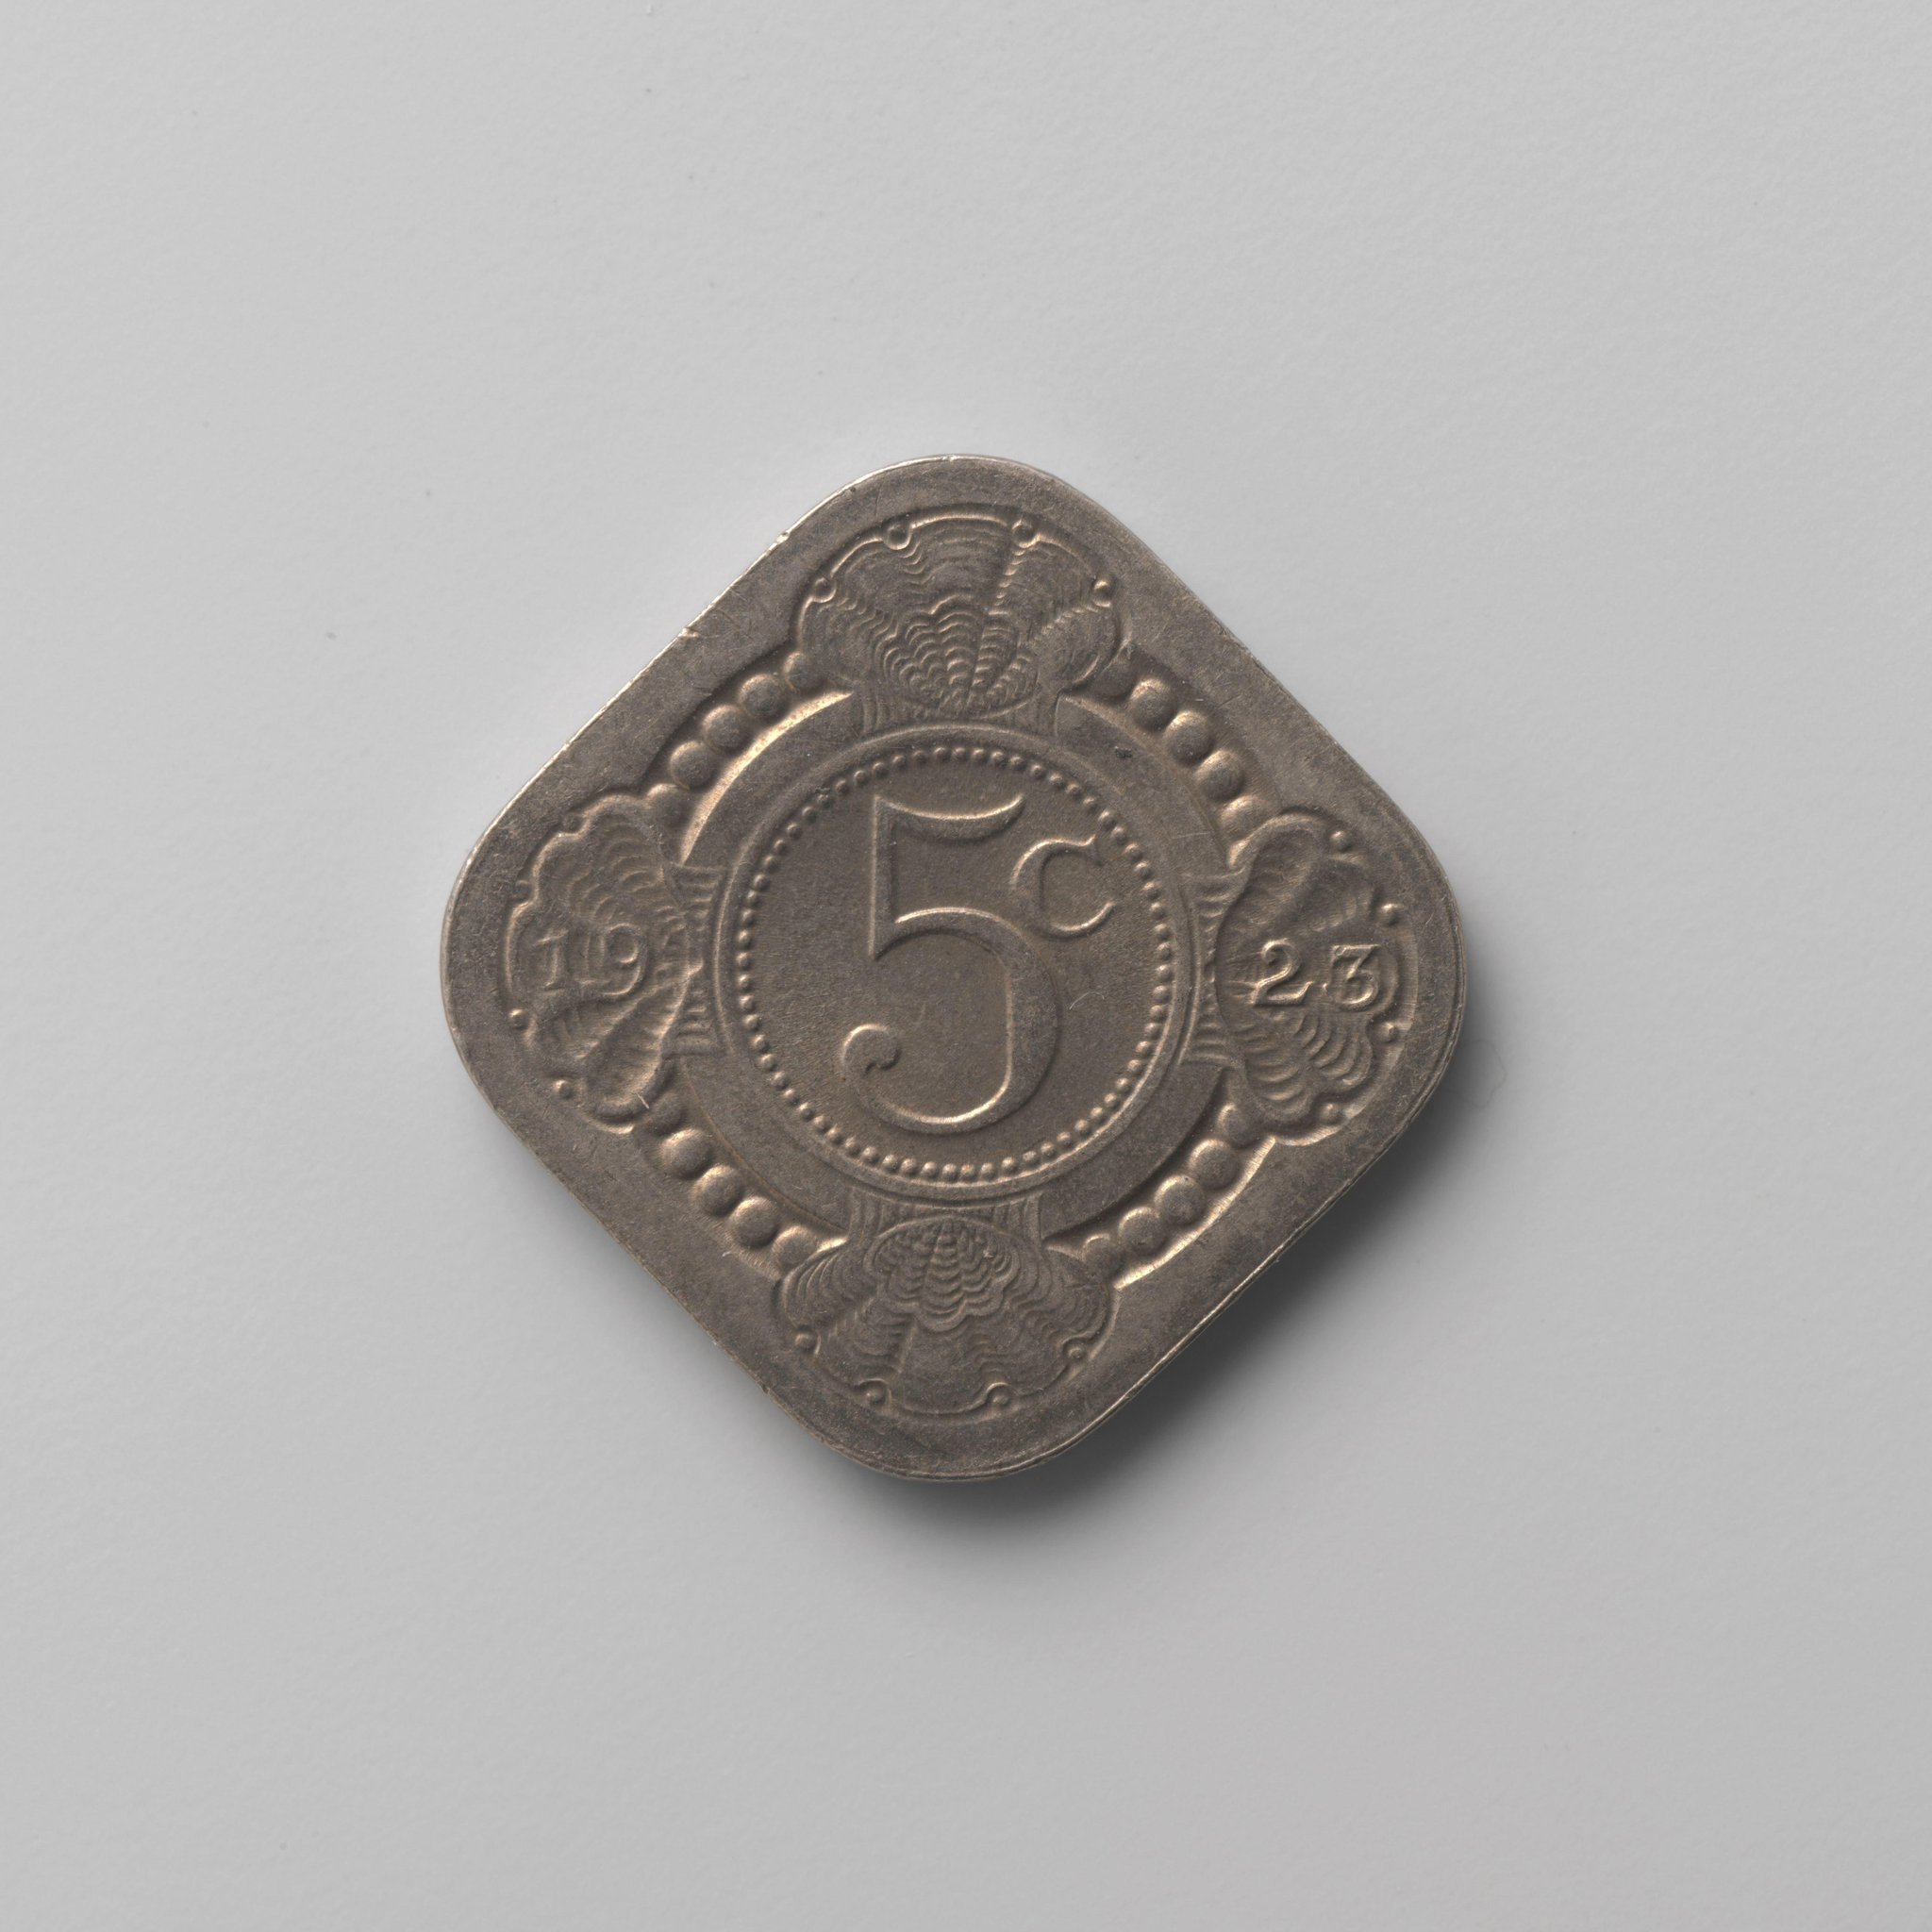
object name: coin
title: Nederlandse 5 cent,1923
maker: wilhelmina of the netherlands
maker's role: print maker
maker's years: 1880-1962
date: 1923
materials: nickel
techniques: striking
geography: utrecht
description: Vierkante nikkelen munt. Voorzijde: in hoeken versiering, daarbinnen twee cirkels, waarin landsaanduiding. Daarbinnen vruchtdragende tak van een oranje-appel. Keerzijde: in de vier hoeken schelpen-versiering, verbonden door parels. Daarbinnen waarde-aanduiding 5 C in parelrand. Jaartal in de twee schelpen links en rechts. Gladde rand.